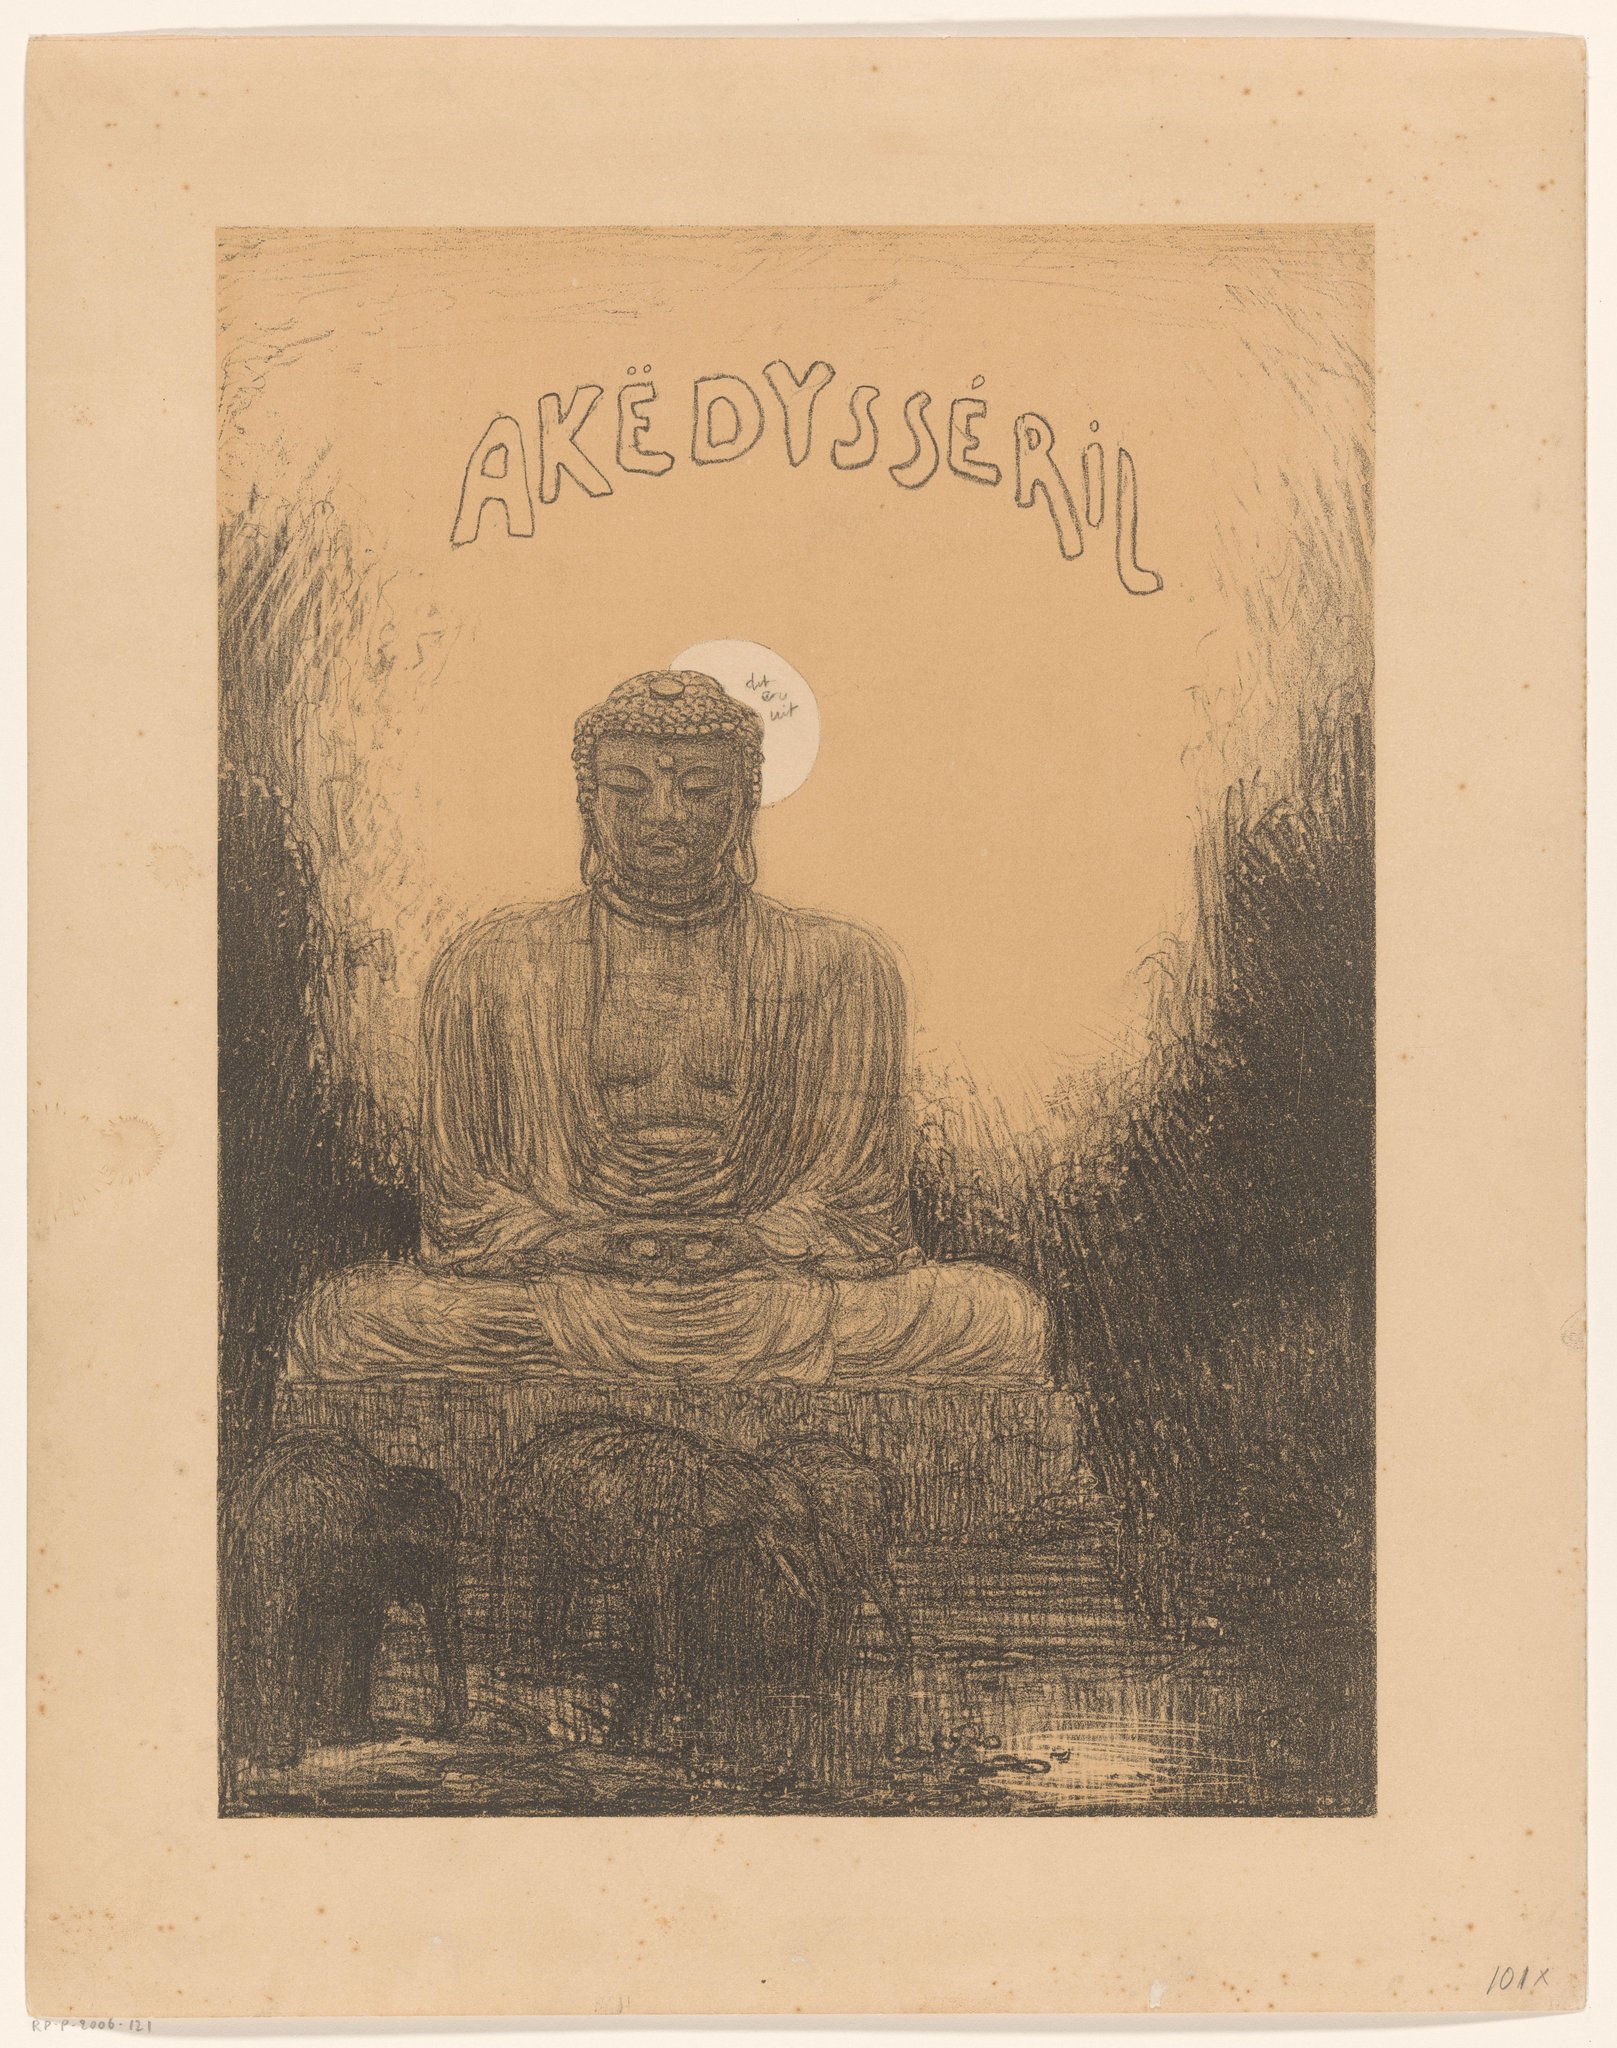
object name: print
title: Ontwerp voor het titelblad van Akëdysséril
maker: marius bauer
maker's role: draughtsman, print maker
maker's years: 1867-1932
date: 1894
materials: paper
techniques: lithograph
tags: hinduism, buddhism, jainism, title-page, trunked animals: elephant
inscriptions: annotation: ‘dit er uit’, collector's mark: Lugt 2228, collector's mark: Lugt 2760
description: Bauer vervaardigde een serie van acht etsen als illustratie bij het prozagedicht Akëdysséril van Villiers de l'Isle Adam, dat door Lodewijk van Deyssel naar het Nederlands vertaald werd. Dit is een ontwerp voor het titelblad van het prentenalbum waarin de etsen werden opgenomen. Een zittende boeddha met ervoor drie olifanten. Rondom het hoofd van de boeddha een cirkel.